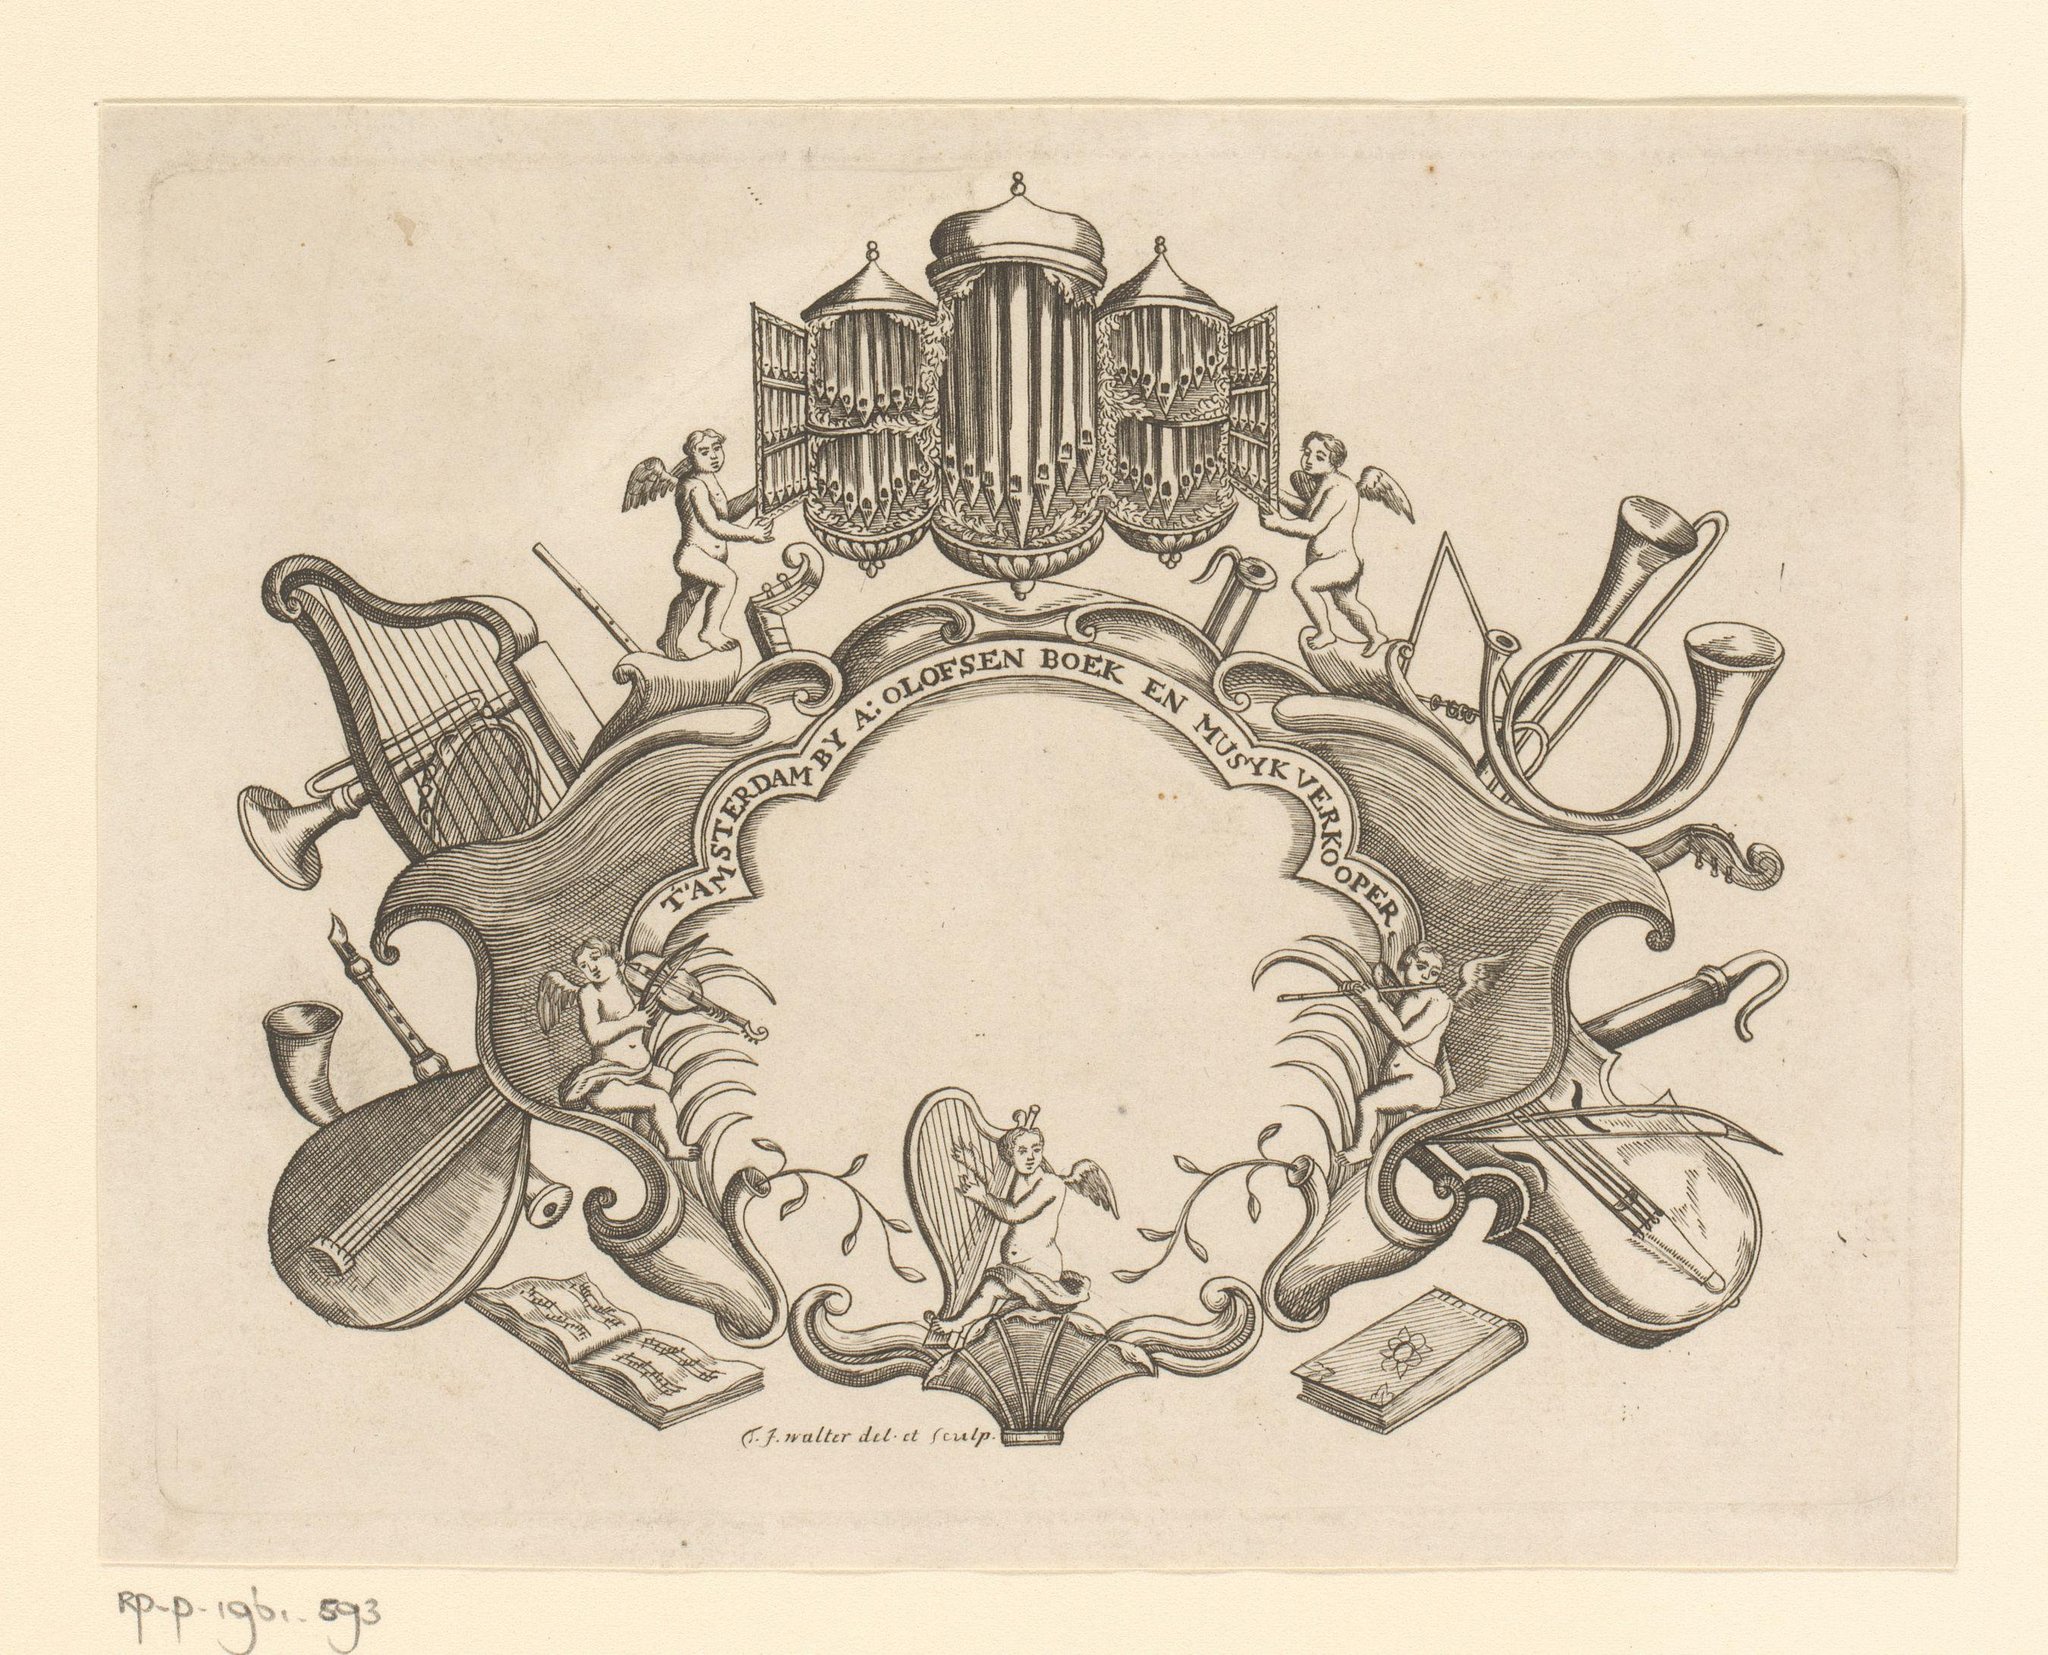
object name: business card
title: Adreskaart van Arnoldus Olofsen, boek- en muziekverkoper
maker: thomas jan walter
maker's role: die cutter, draughtsman, print maker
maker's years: -1790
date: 1765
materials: paper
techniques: etching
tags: bookseller, arnoldus olofsen, musical instruments; group of musical instruments, organ, cupids: 'amores', 'amoretti', 'putti'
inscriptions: collector's mark: Lugt 2228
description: Een cartouche met bovenin de tekst: 'T'Amsterdam by A: Olofsen boek en musyk verkooper'. Bovenaan het cartouche een orgel, onderaan een harpspelende engel. Aan weerszijden van het cartouche muziekinstrumenten.